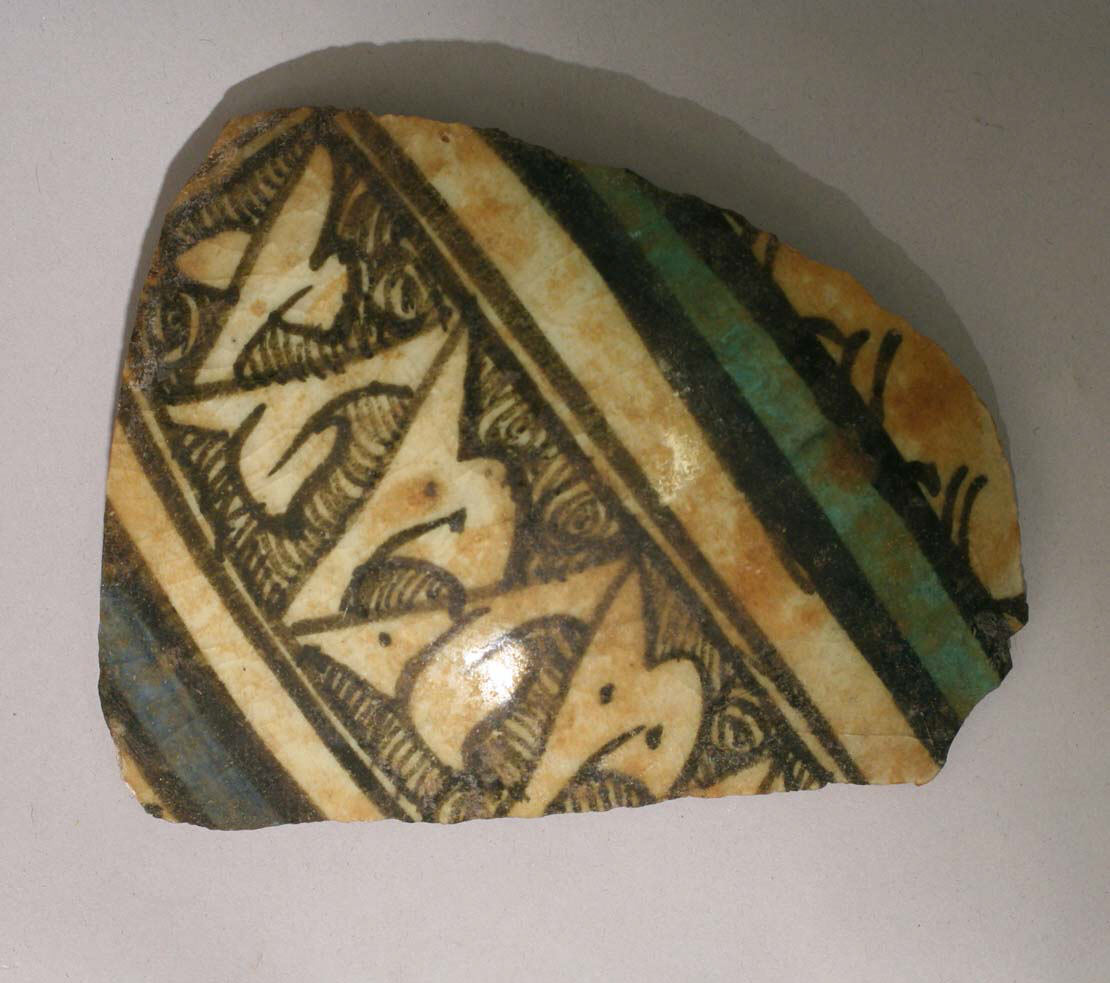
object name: ceramic fragment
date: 1301-1400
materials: glaze, stonepaste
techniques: painting, polychrome, underglaze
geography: syria